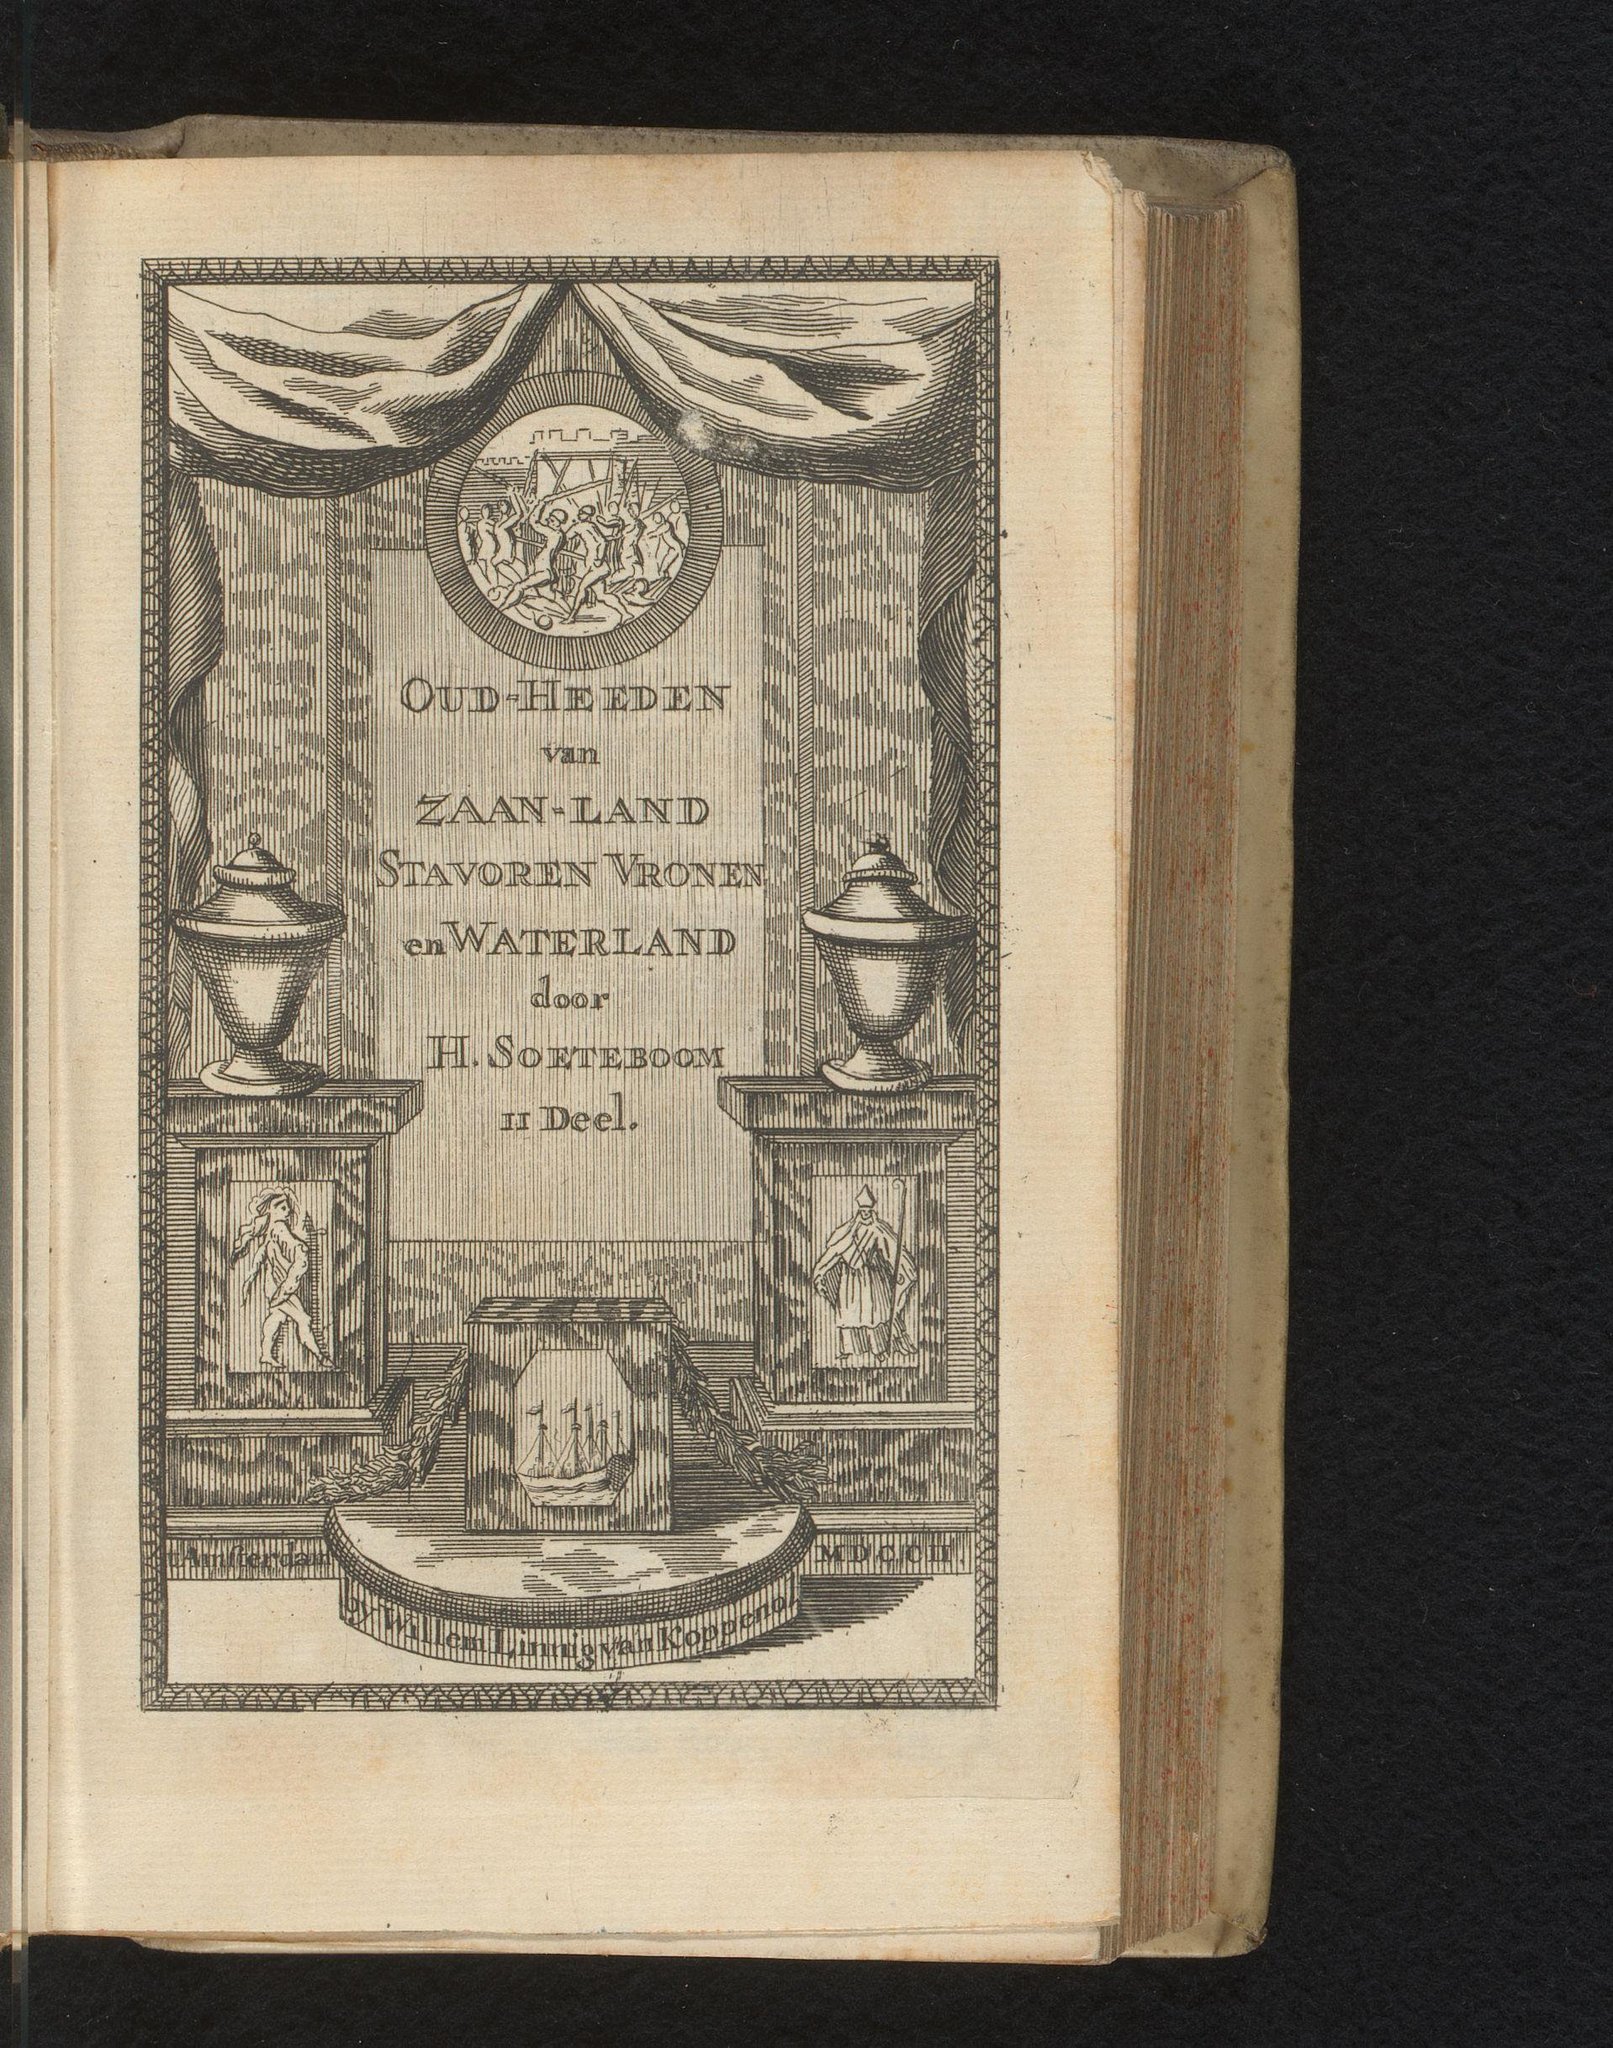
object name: print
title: Oud-Heeden van Zaan-land Stavoren Vronen en Waterland door H. Soetboom II Deel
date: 1700-1702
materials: paper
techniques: etching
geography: amsterdam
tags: vronen, zaanstreek, stavoren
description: Illustratie in: H. Soeteboom, Oud-heden van Zaan-land, Stavoren, Vronen en Waterland : deze laatste druk ... met nodige aanteekeningen, figuren, en een landkaart verrykt, W. Linnig van Koppenol, Amsterdam 1702, dl. 2, titelprent.